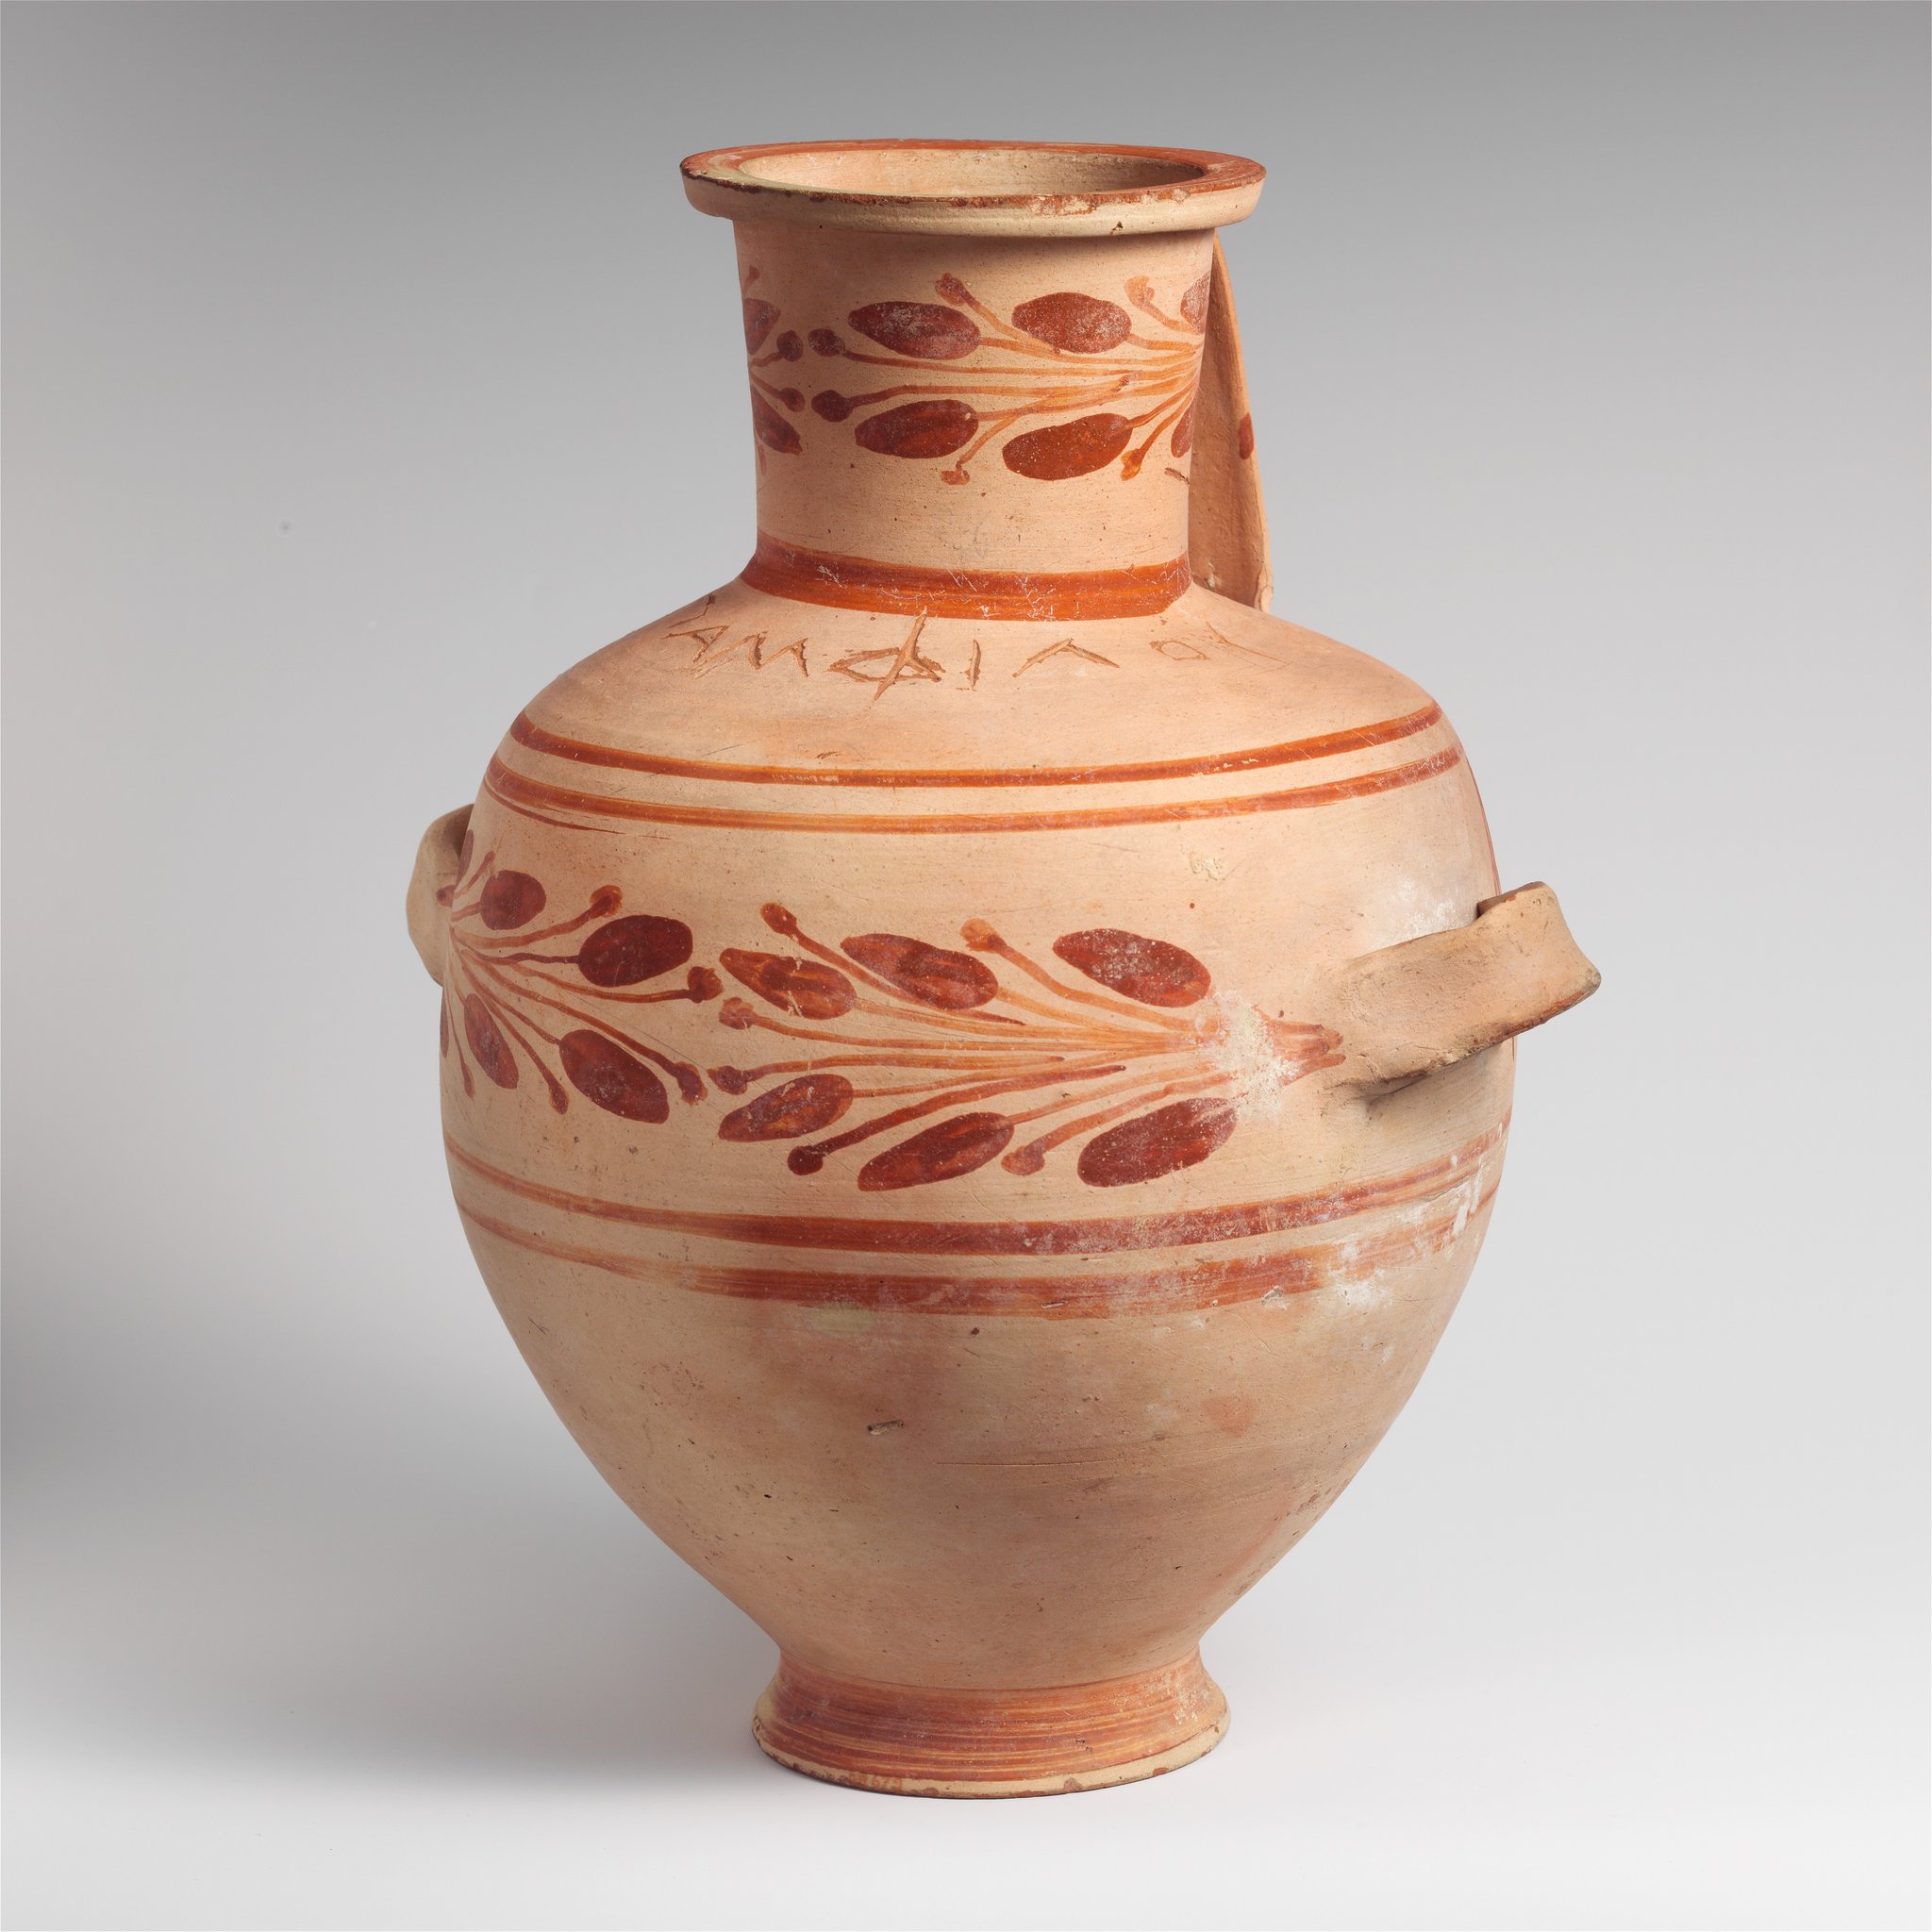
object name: hydria, hadra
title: Terracotta Hadra hydria (water jar)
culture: greek, ptolemaic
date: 300-201 BCE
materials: terracotta